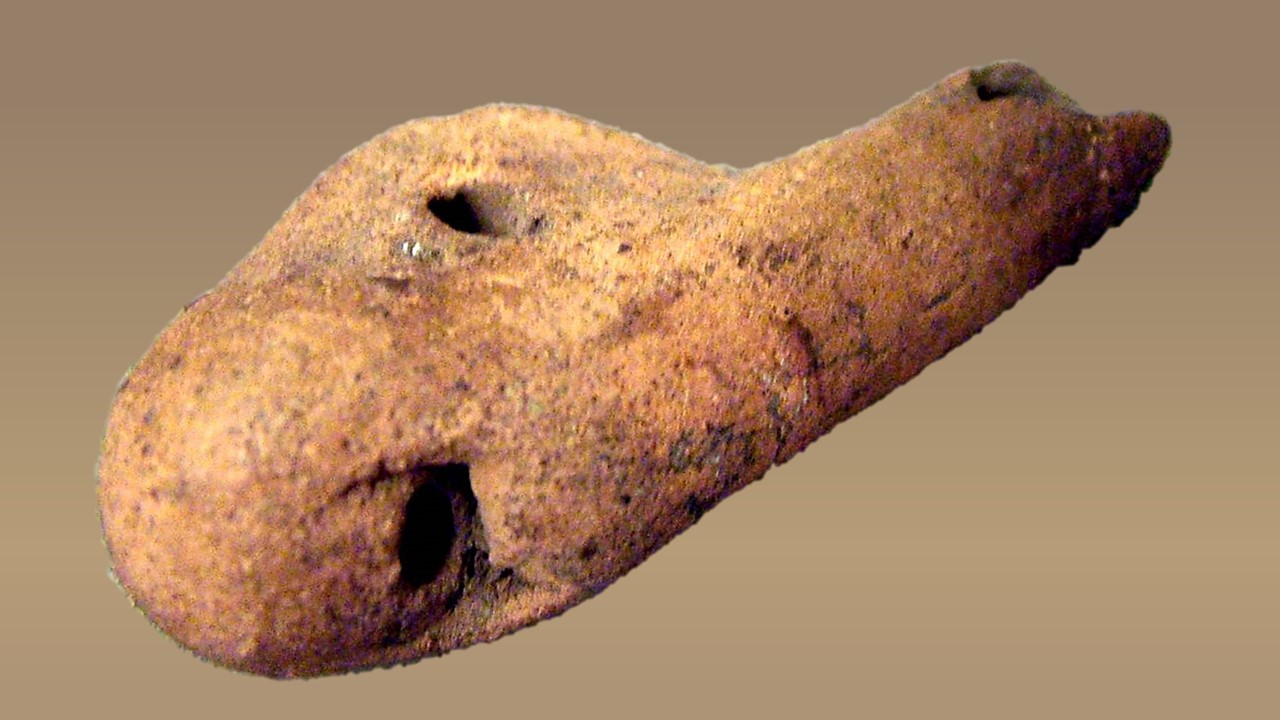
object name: pottery whistle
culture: mexican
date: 1801-1900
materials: clay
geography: mexico